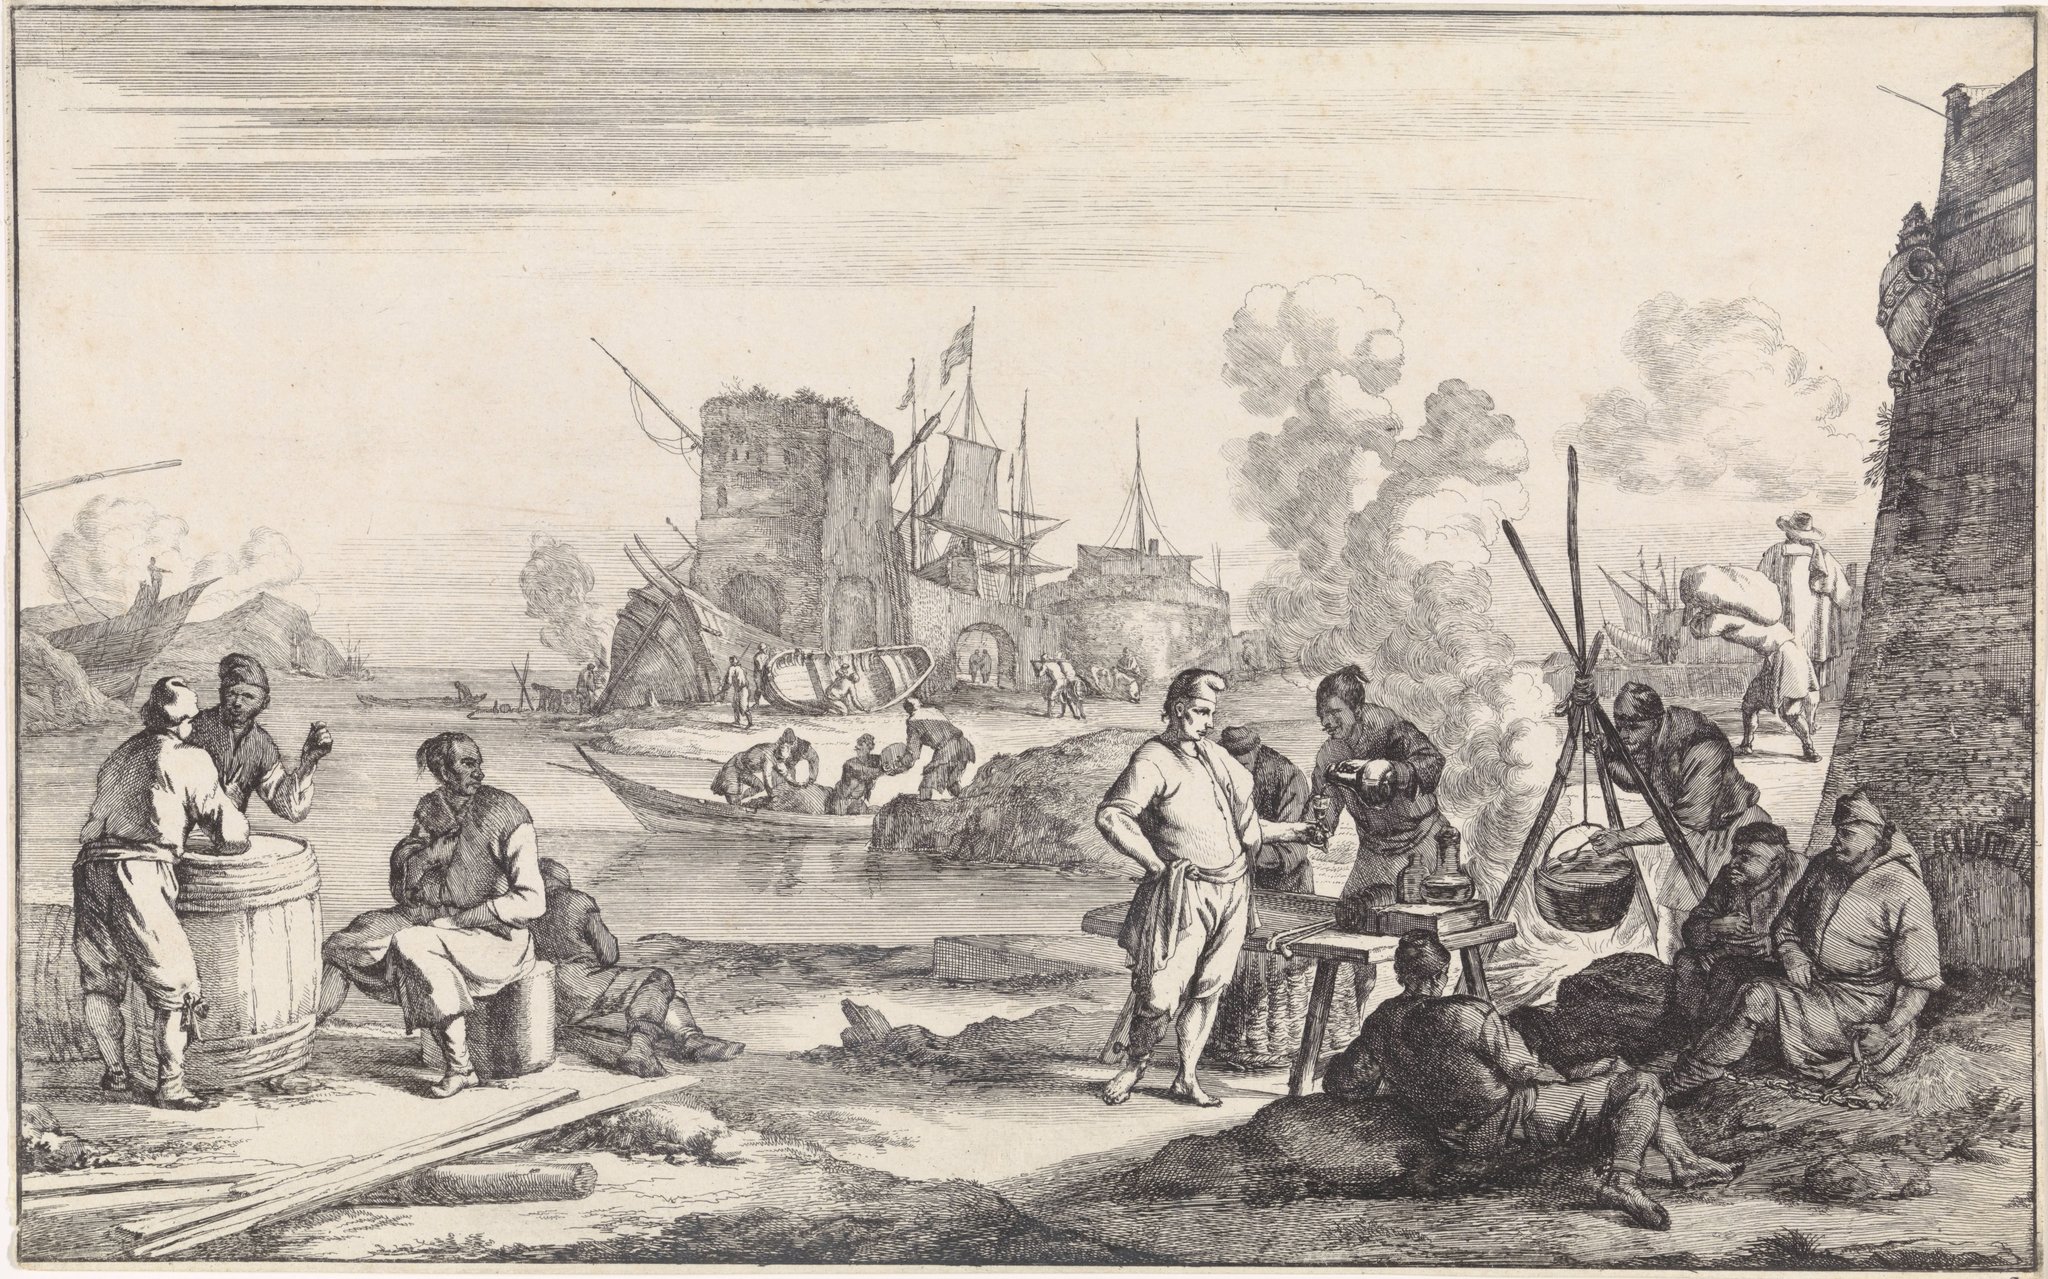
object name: print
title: Havens van Genua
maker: anthony van zijlvelt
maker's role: print maker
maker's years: 1637-1715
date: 1650-1695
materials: paper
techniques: etching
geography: amsterdam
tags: harbour, wooden container: barrel, cask, bucket, accessories ~ fire-place, landscape with ruins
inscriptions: collector's mark: Lugt 11, collector's mark: Lugt 10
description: Verschillende zeelieden rond een ton en rond een vuur op de waterkant. Op de achtergrond de ruïne van een toren en verschillende schepen.